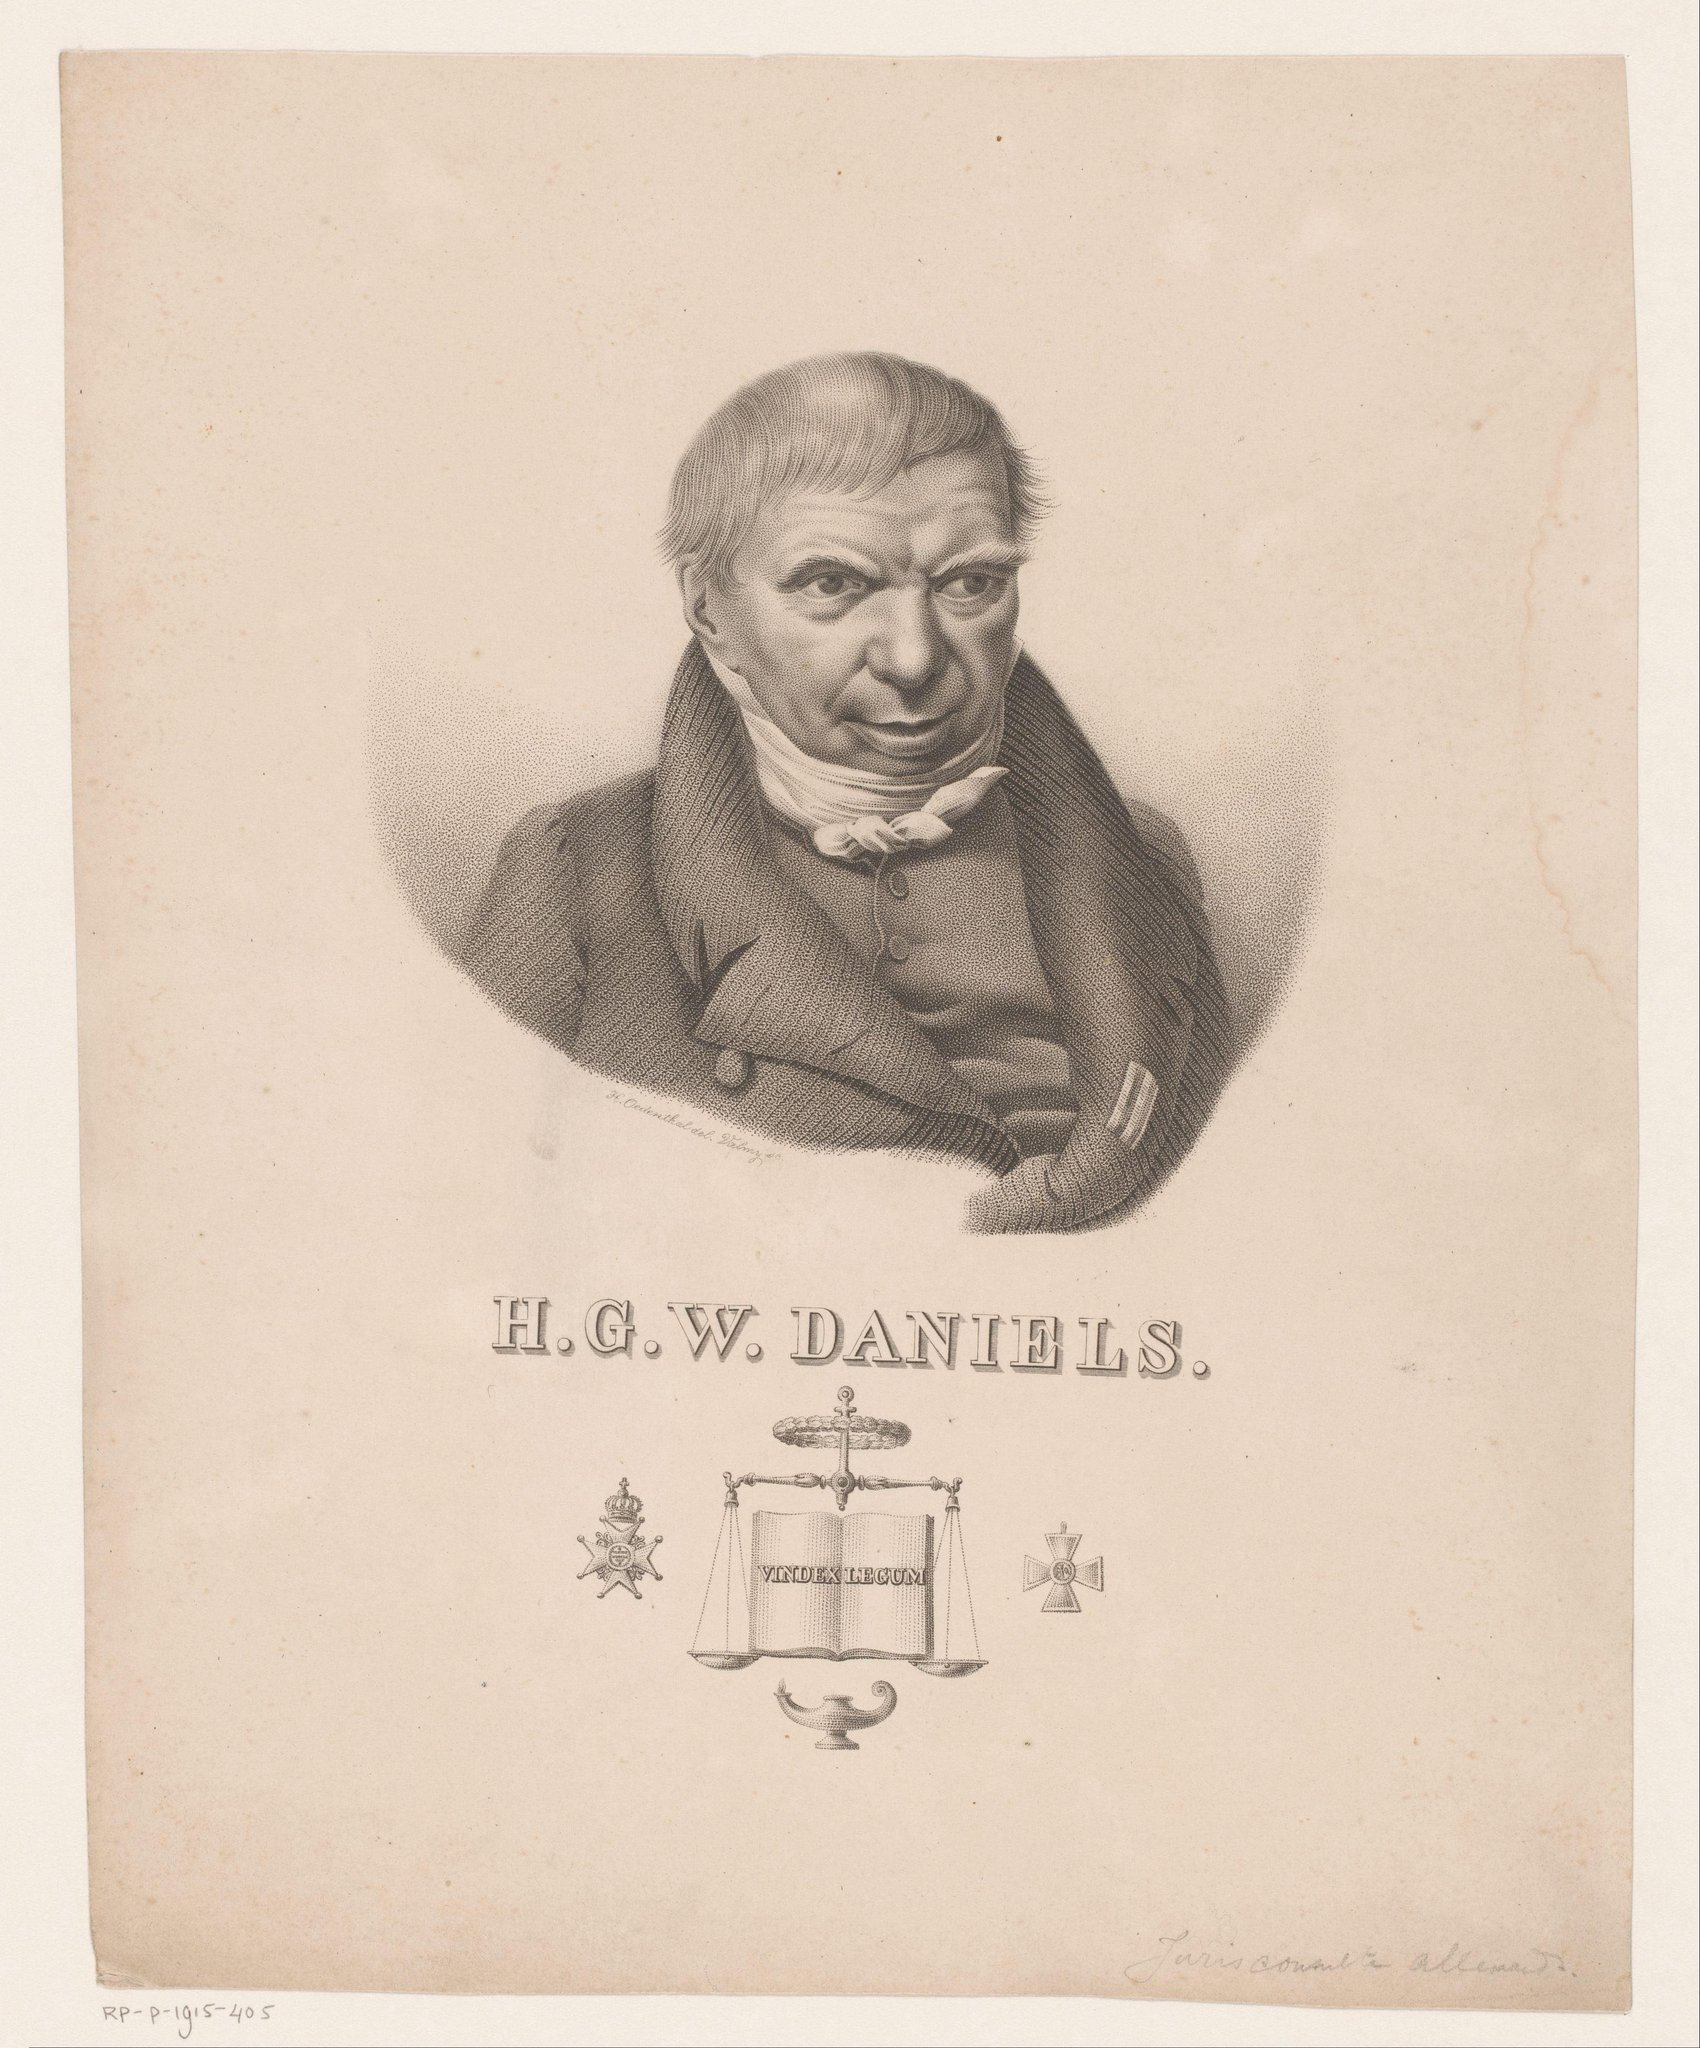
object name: print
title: Portret van Heinrich Gottfried Wilhelm Daniels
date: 1801-1850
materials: paper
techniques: etching, roulette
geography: germany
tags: historical persons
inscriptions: collector's mark: Lugt 2228